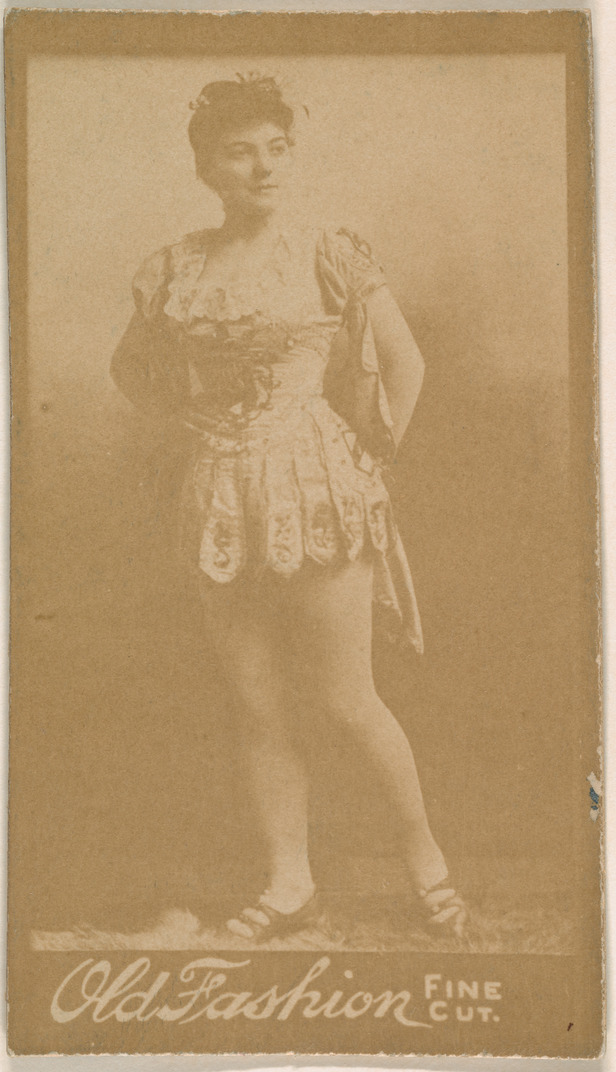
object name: photograph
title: Actress standing with hands behind back, from the Actresses series (N664) promoting Old Fashion Fine Cut Tobacco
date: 1888-1890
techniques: albumen silver print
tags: portraits,women,actresses